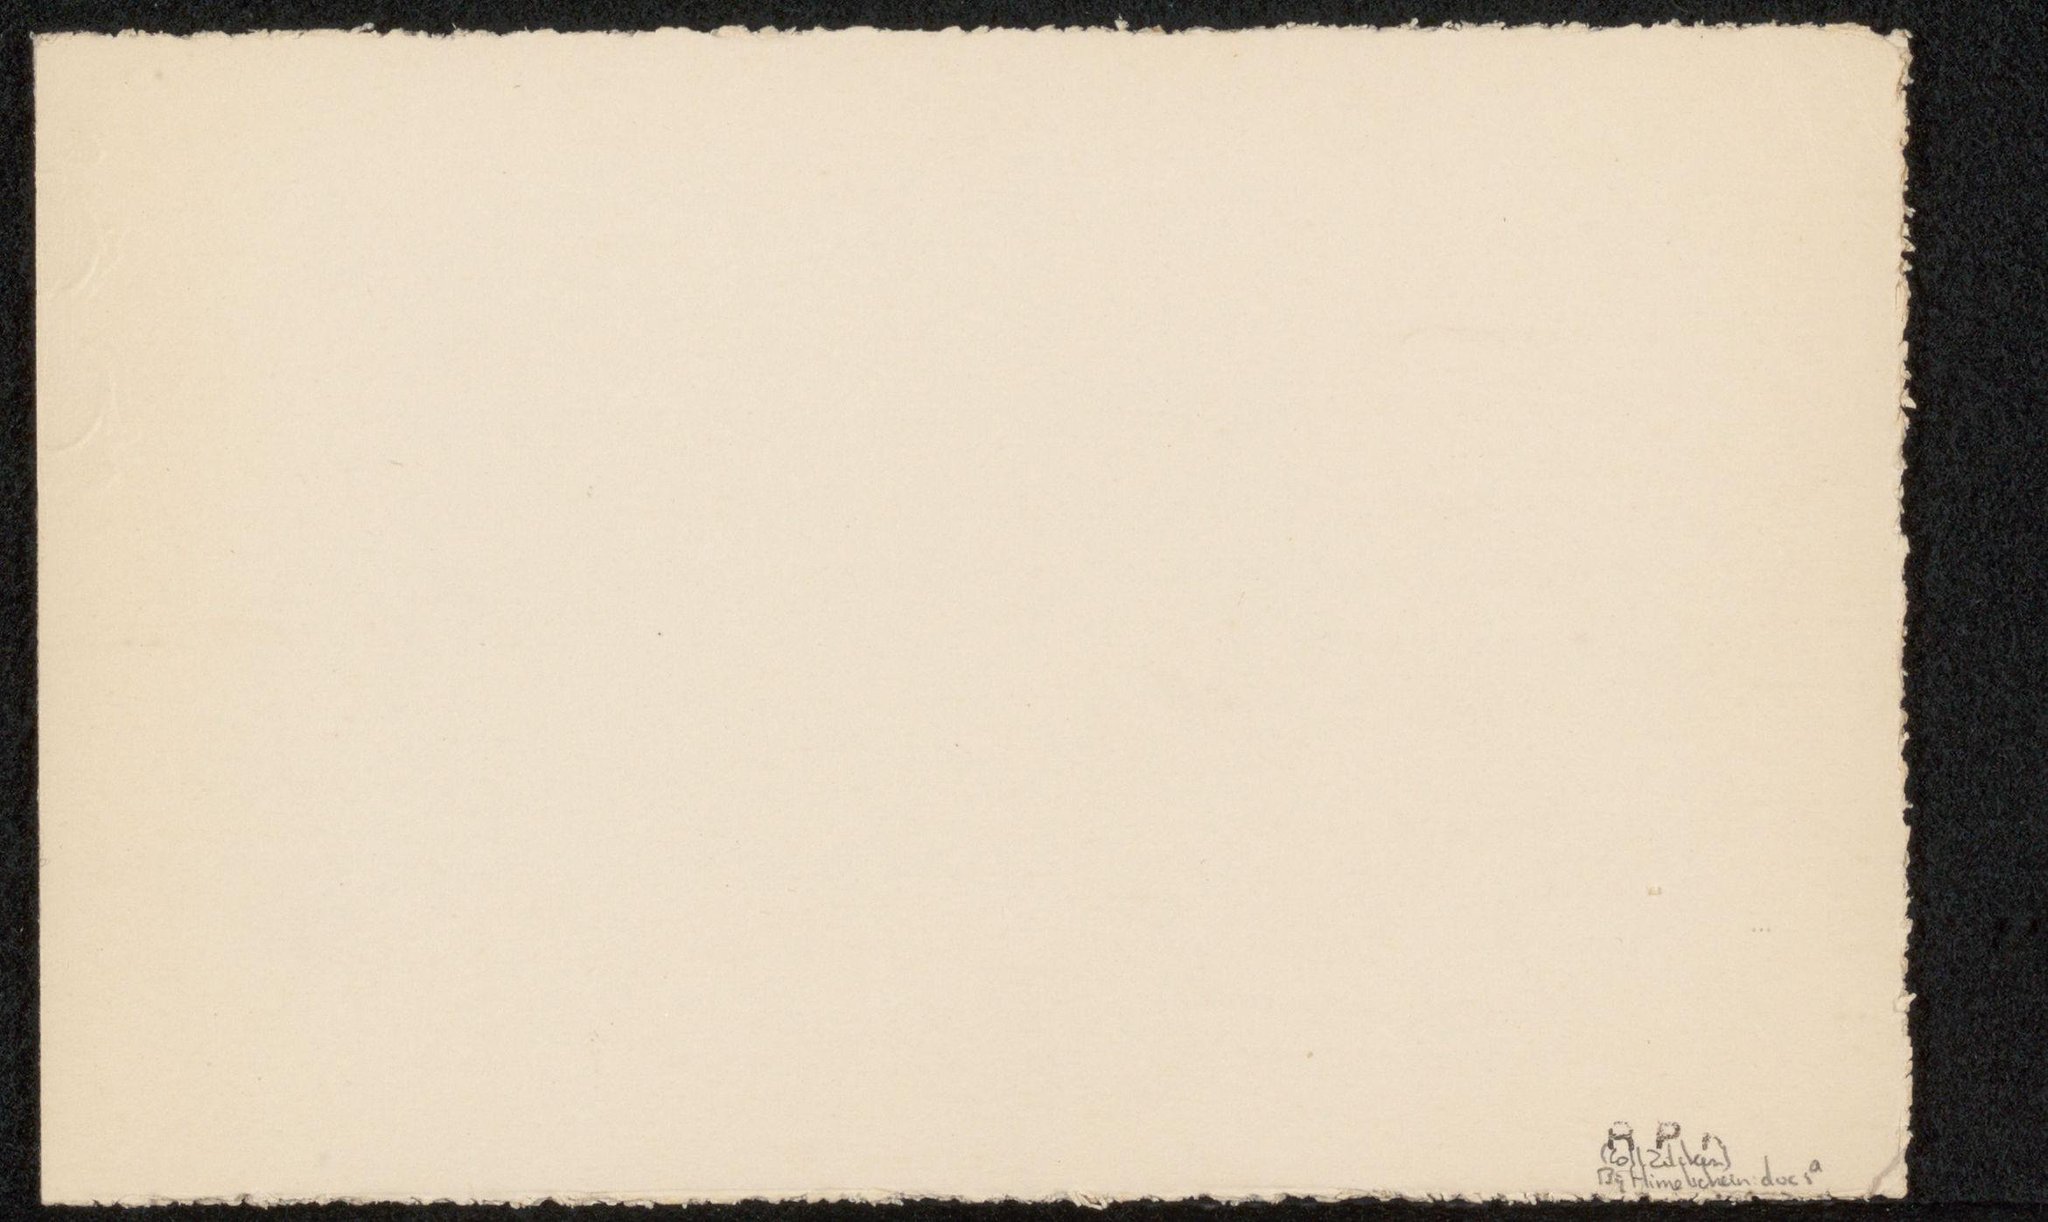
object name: wedding announcement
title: Huwelijksaankondiging aan Henriette Wilhelmina van Baak en Philip Zilcken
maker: Anonymous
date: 1921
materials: cardboard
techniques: printing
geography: paris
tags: painter, draughtsman, rose imel, henriette wilhelmina van baak, philip zilcken, antwerp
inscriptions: collector's mark: ‘RPK’, monogram: ‘SH’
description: Huwelijksaankondiging is samen met bijlage RP-D-1982-43-HIMELSCHEIN-DOC.1B verstuurd in één envelop.